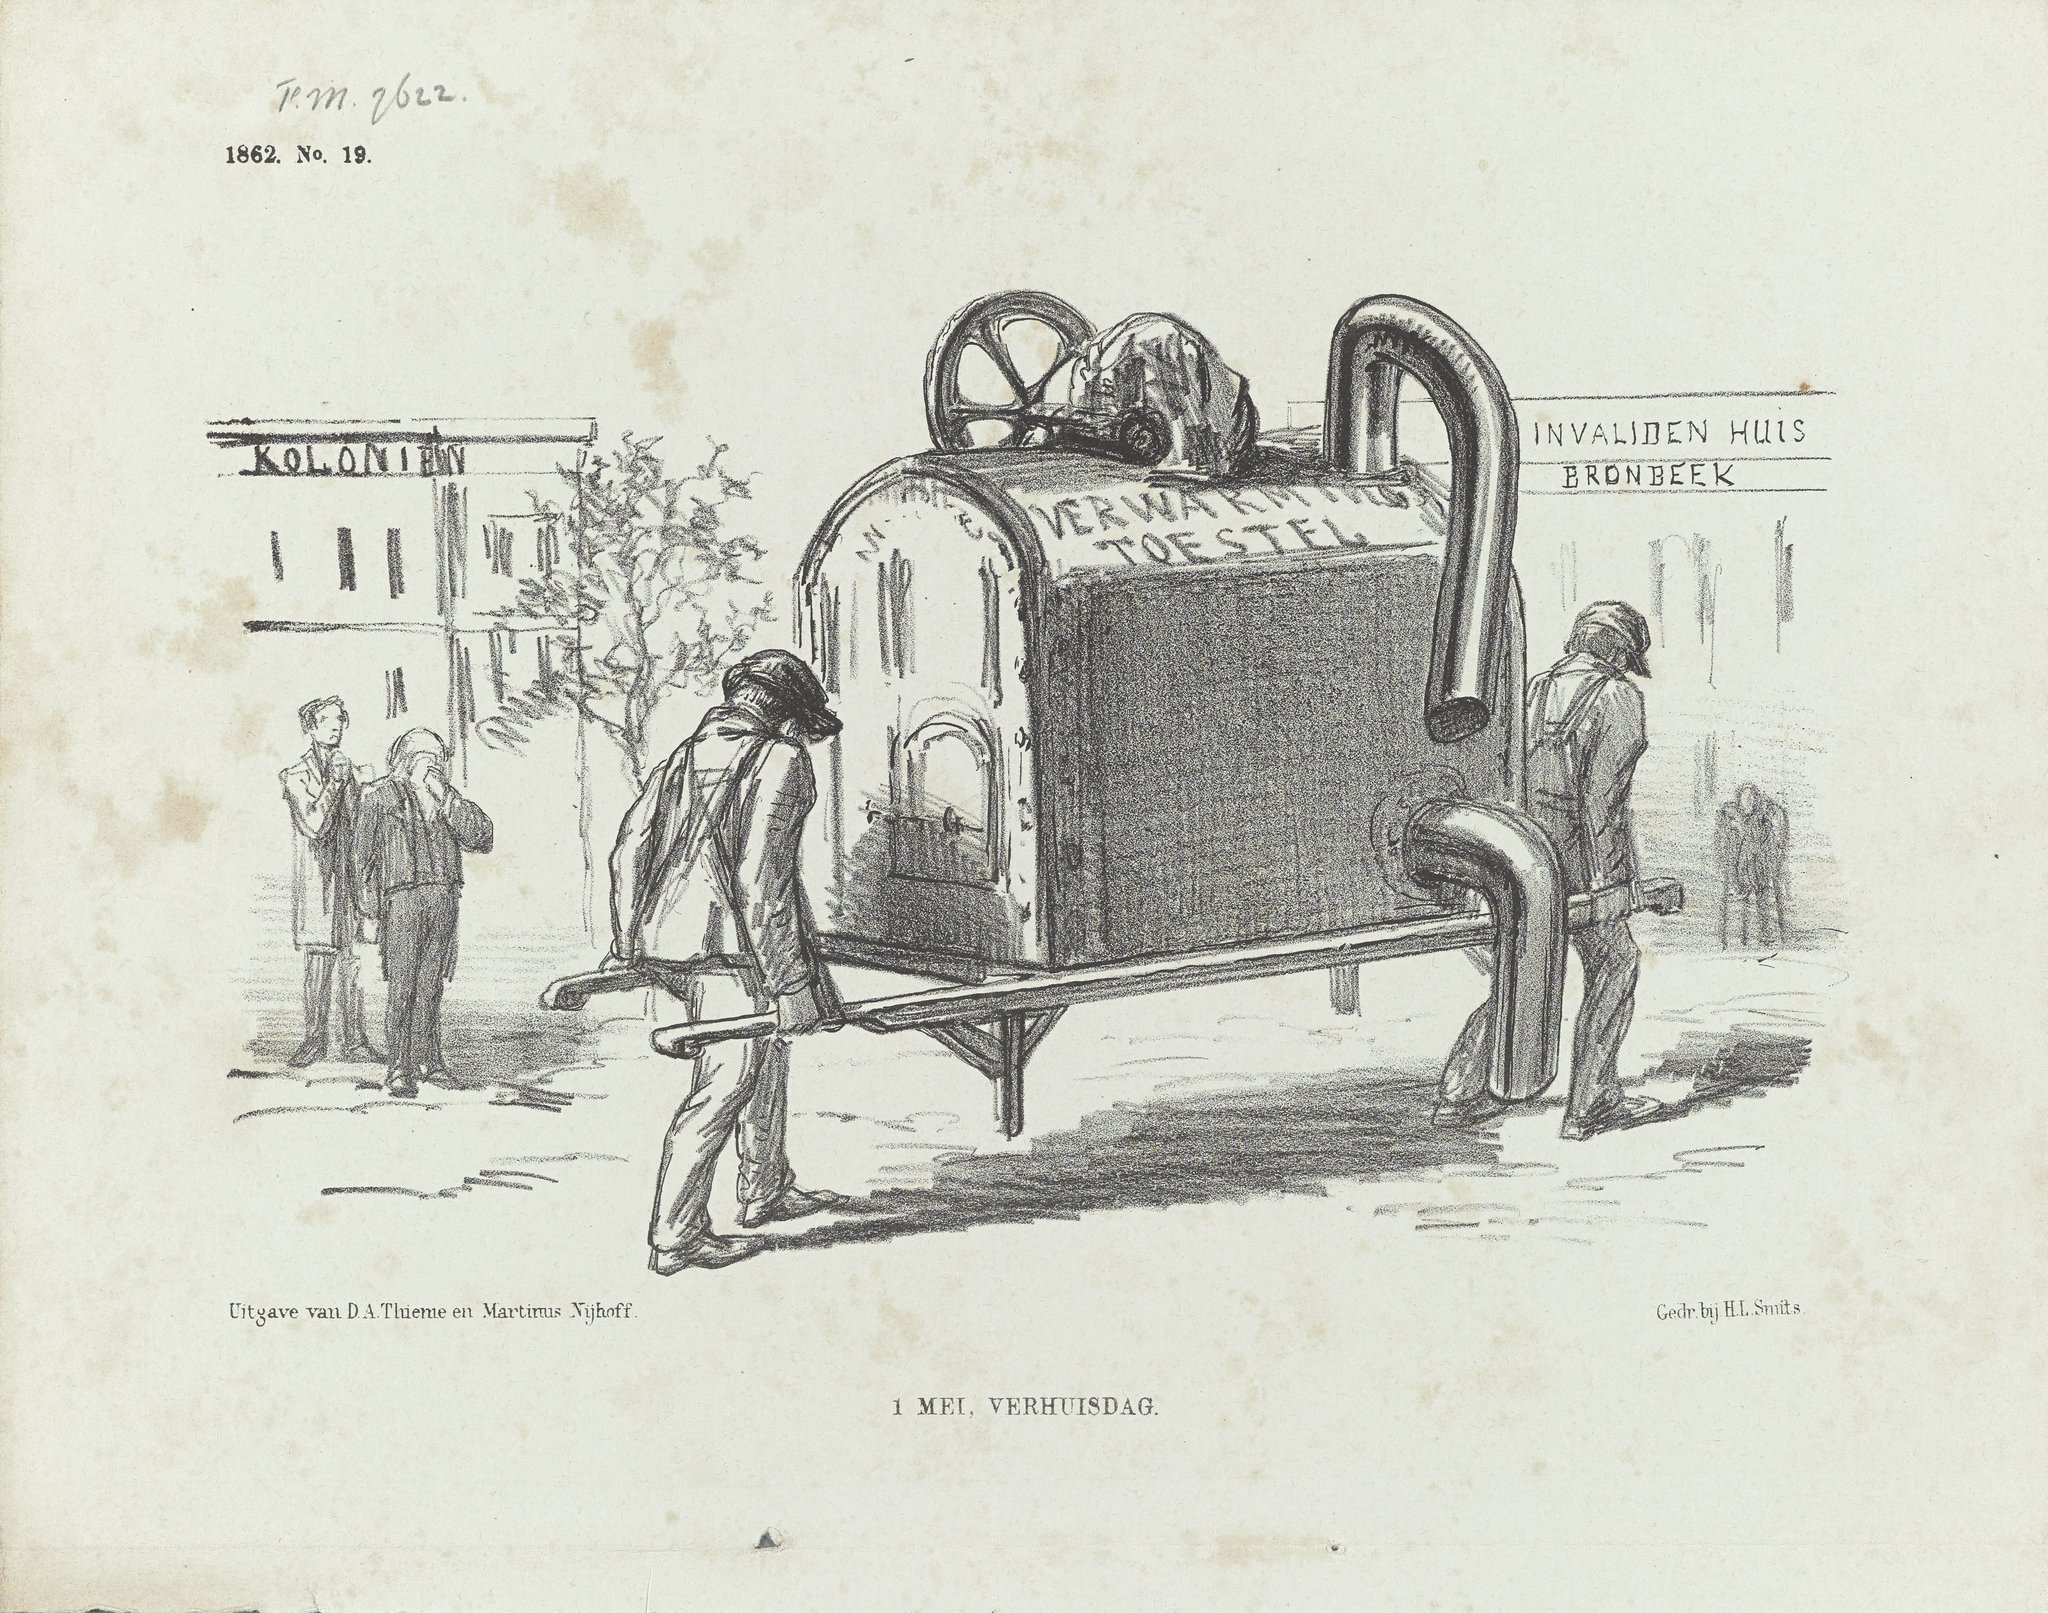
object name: cartoon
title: 1 Mei, verhuisdag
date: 1862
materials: paper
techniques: lithograph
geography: arnhem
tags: heating stove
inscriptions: collector's mark: Lugt 2228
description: Spotprent op het mislukte verwarmingstoestel van het Ministerie van Koloniën dat naar het Invalidenhuis Bronbeek is overgebracht. Plaat verschenen bij het weekblad De Nederlandsche Spectator, nr. 19, 10 mei 1862.